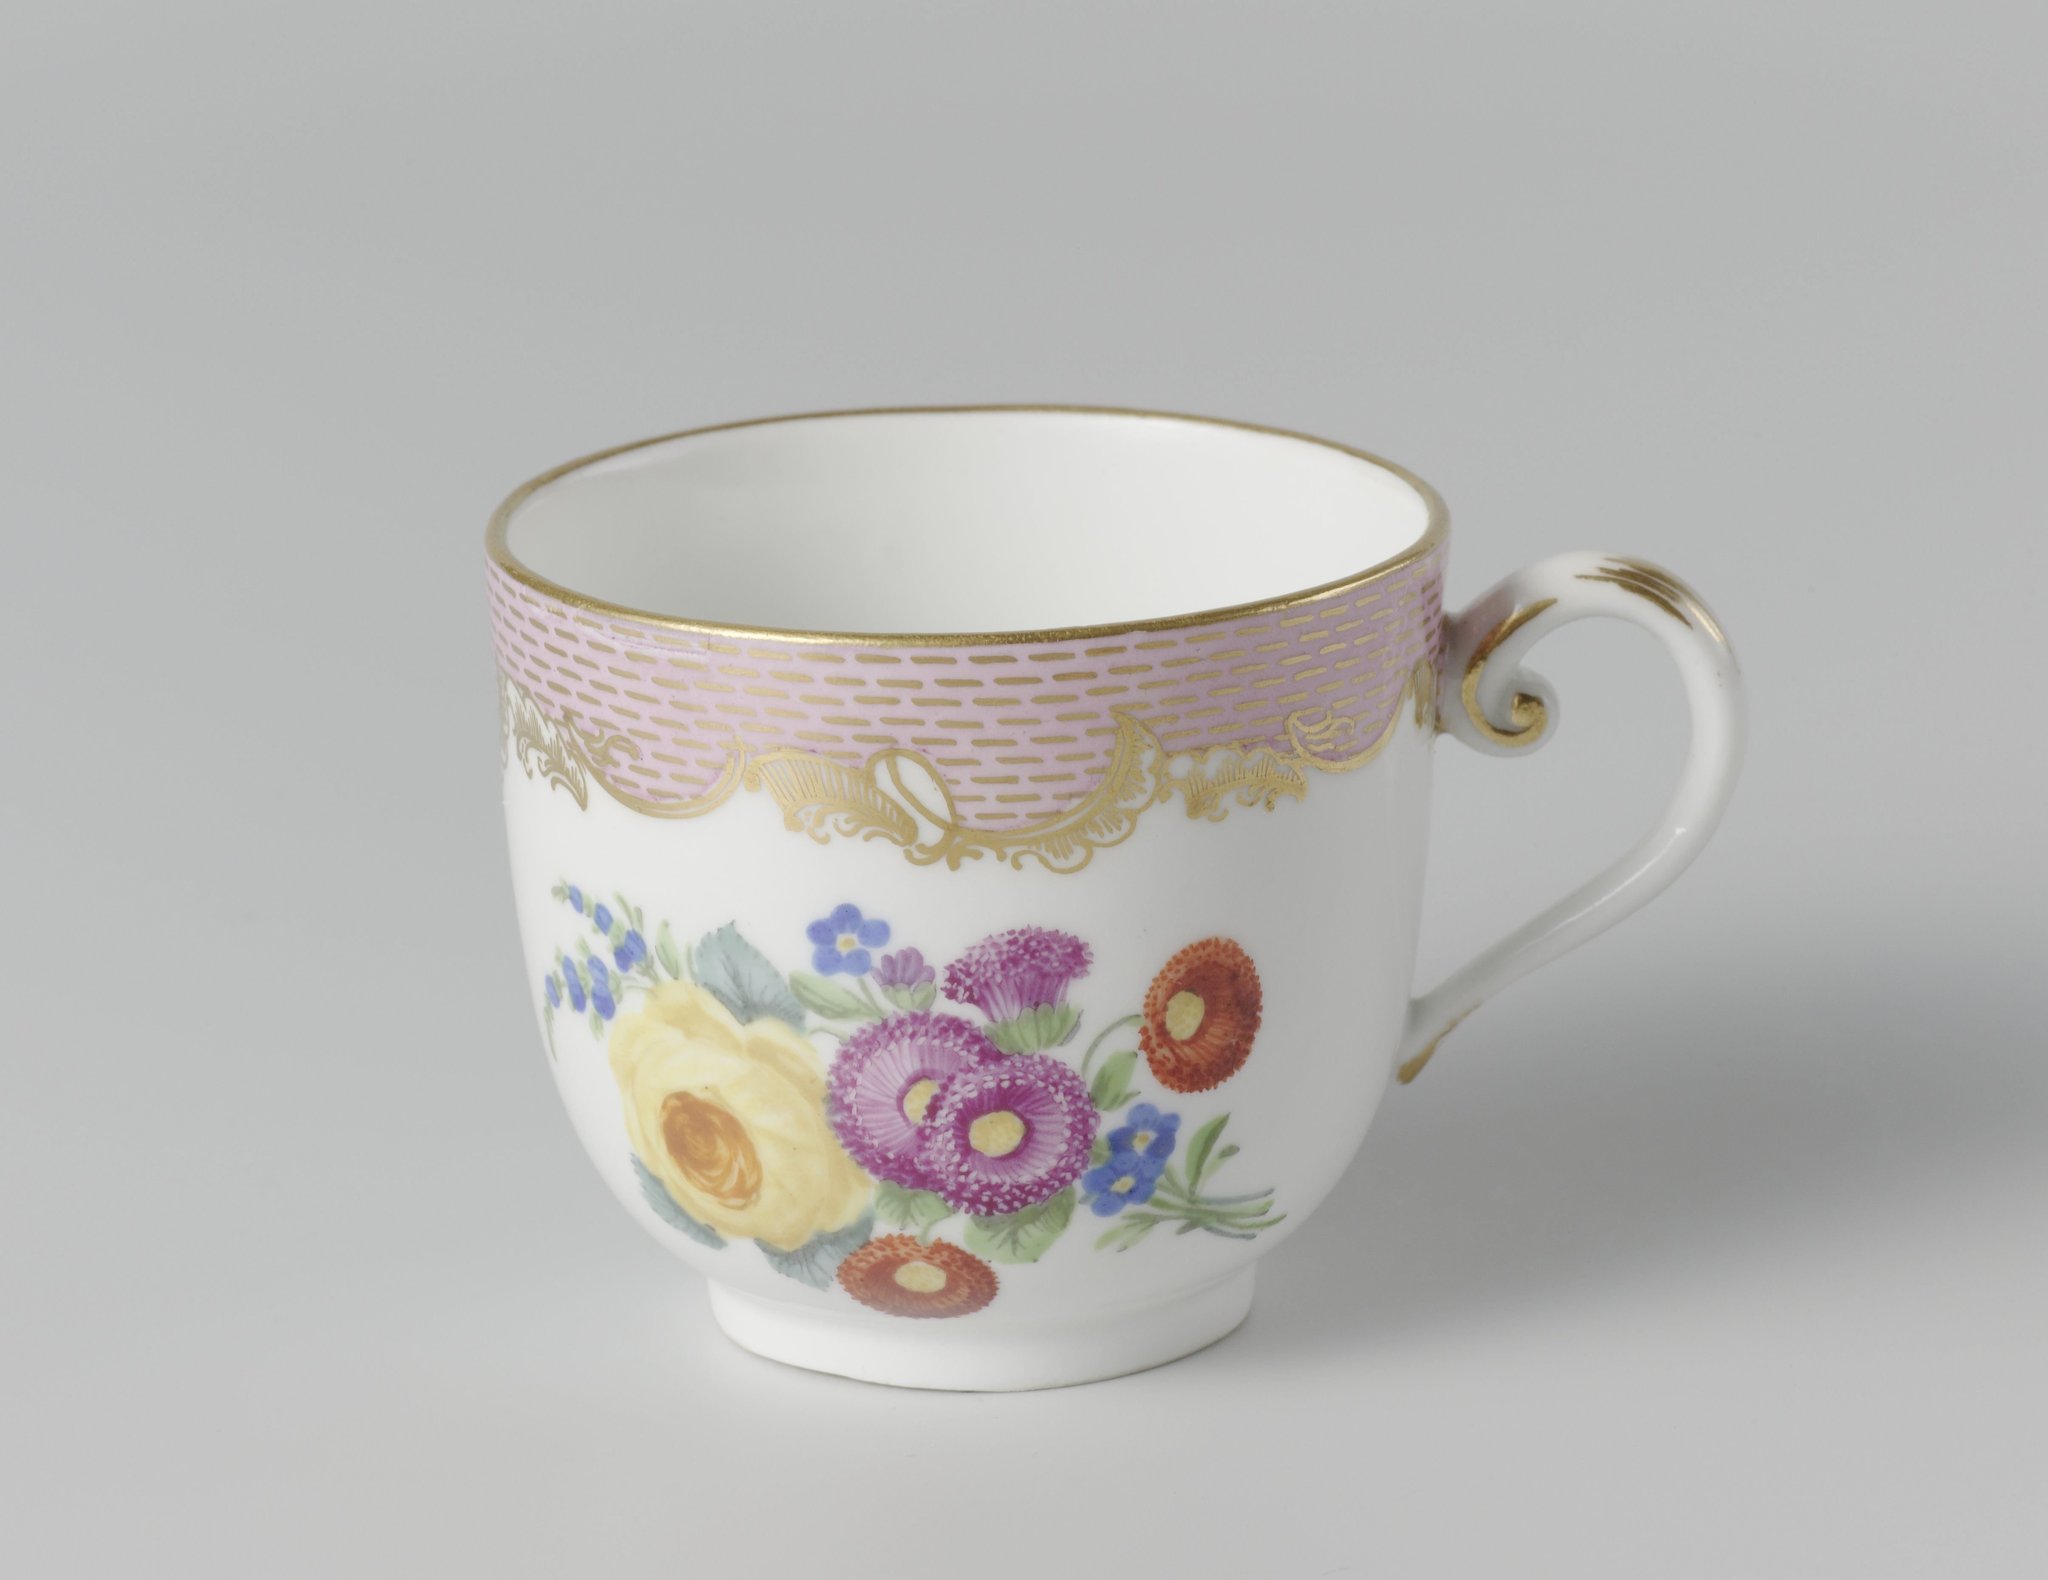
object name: cup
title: Kop, veelkleurig beschilderd met bloemboeketten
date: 1800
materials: porcelain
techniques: painted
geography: meissen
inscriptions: factory mark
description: Hoge kop met oor van beschilderd porselein. De kop is beschilderd met bloemboeketten en langs de rand een brede strook met strepen in goud op een rose fond, steeds afgezet met een rocaille-ornament in goud. De kop is gemerkt.